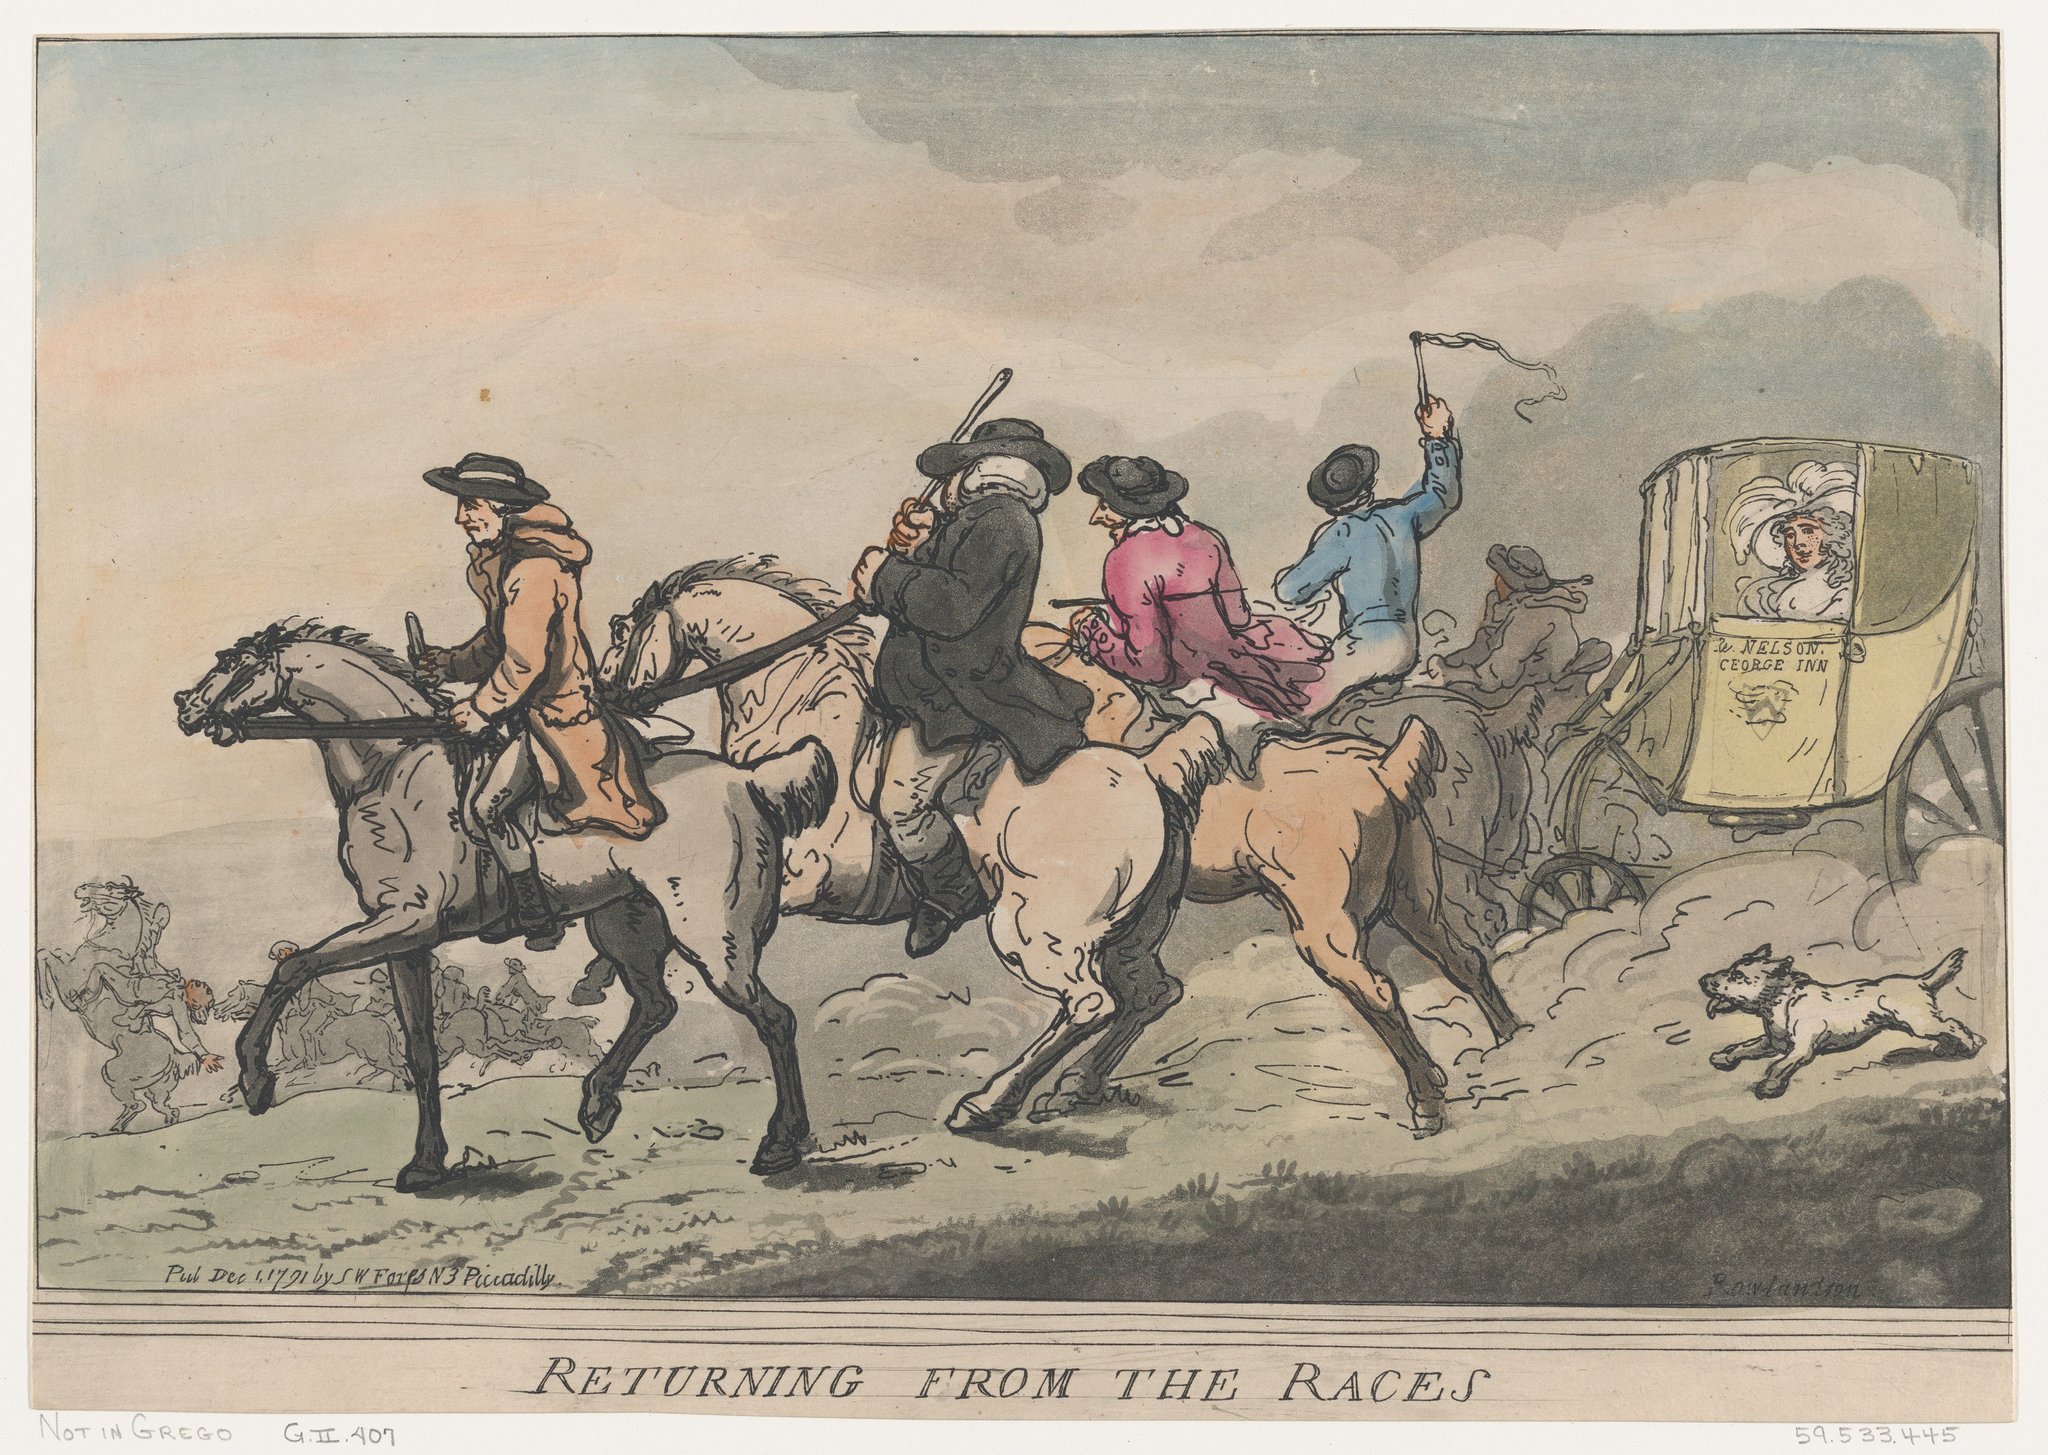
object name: print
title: Returning from the Races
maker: thomas rowlandson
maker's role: artist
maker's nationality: british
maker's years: 1757-1827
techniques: etching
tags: men,women,dogs,horses,carriages